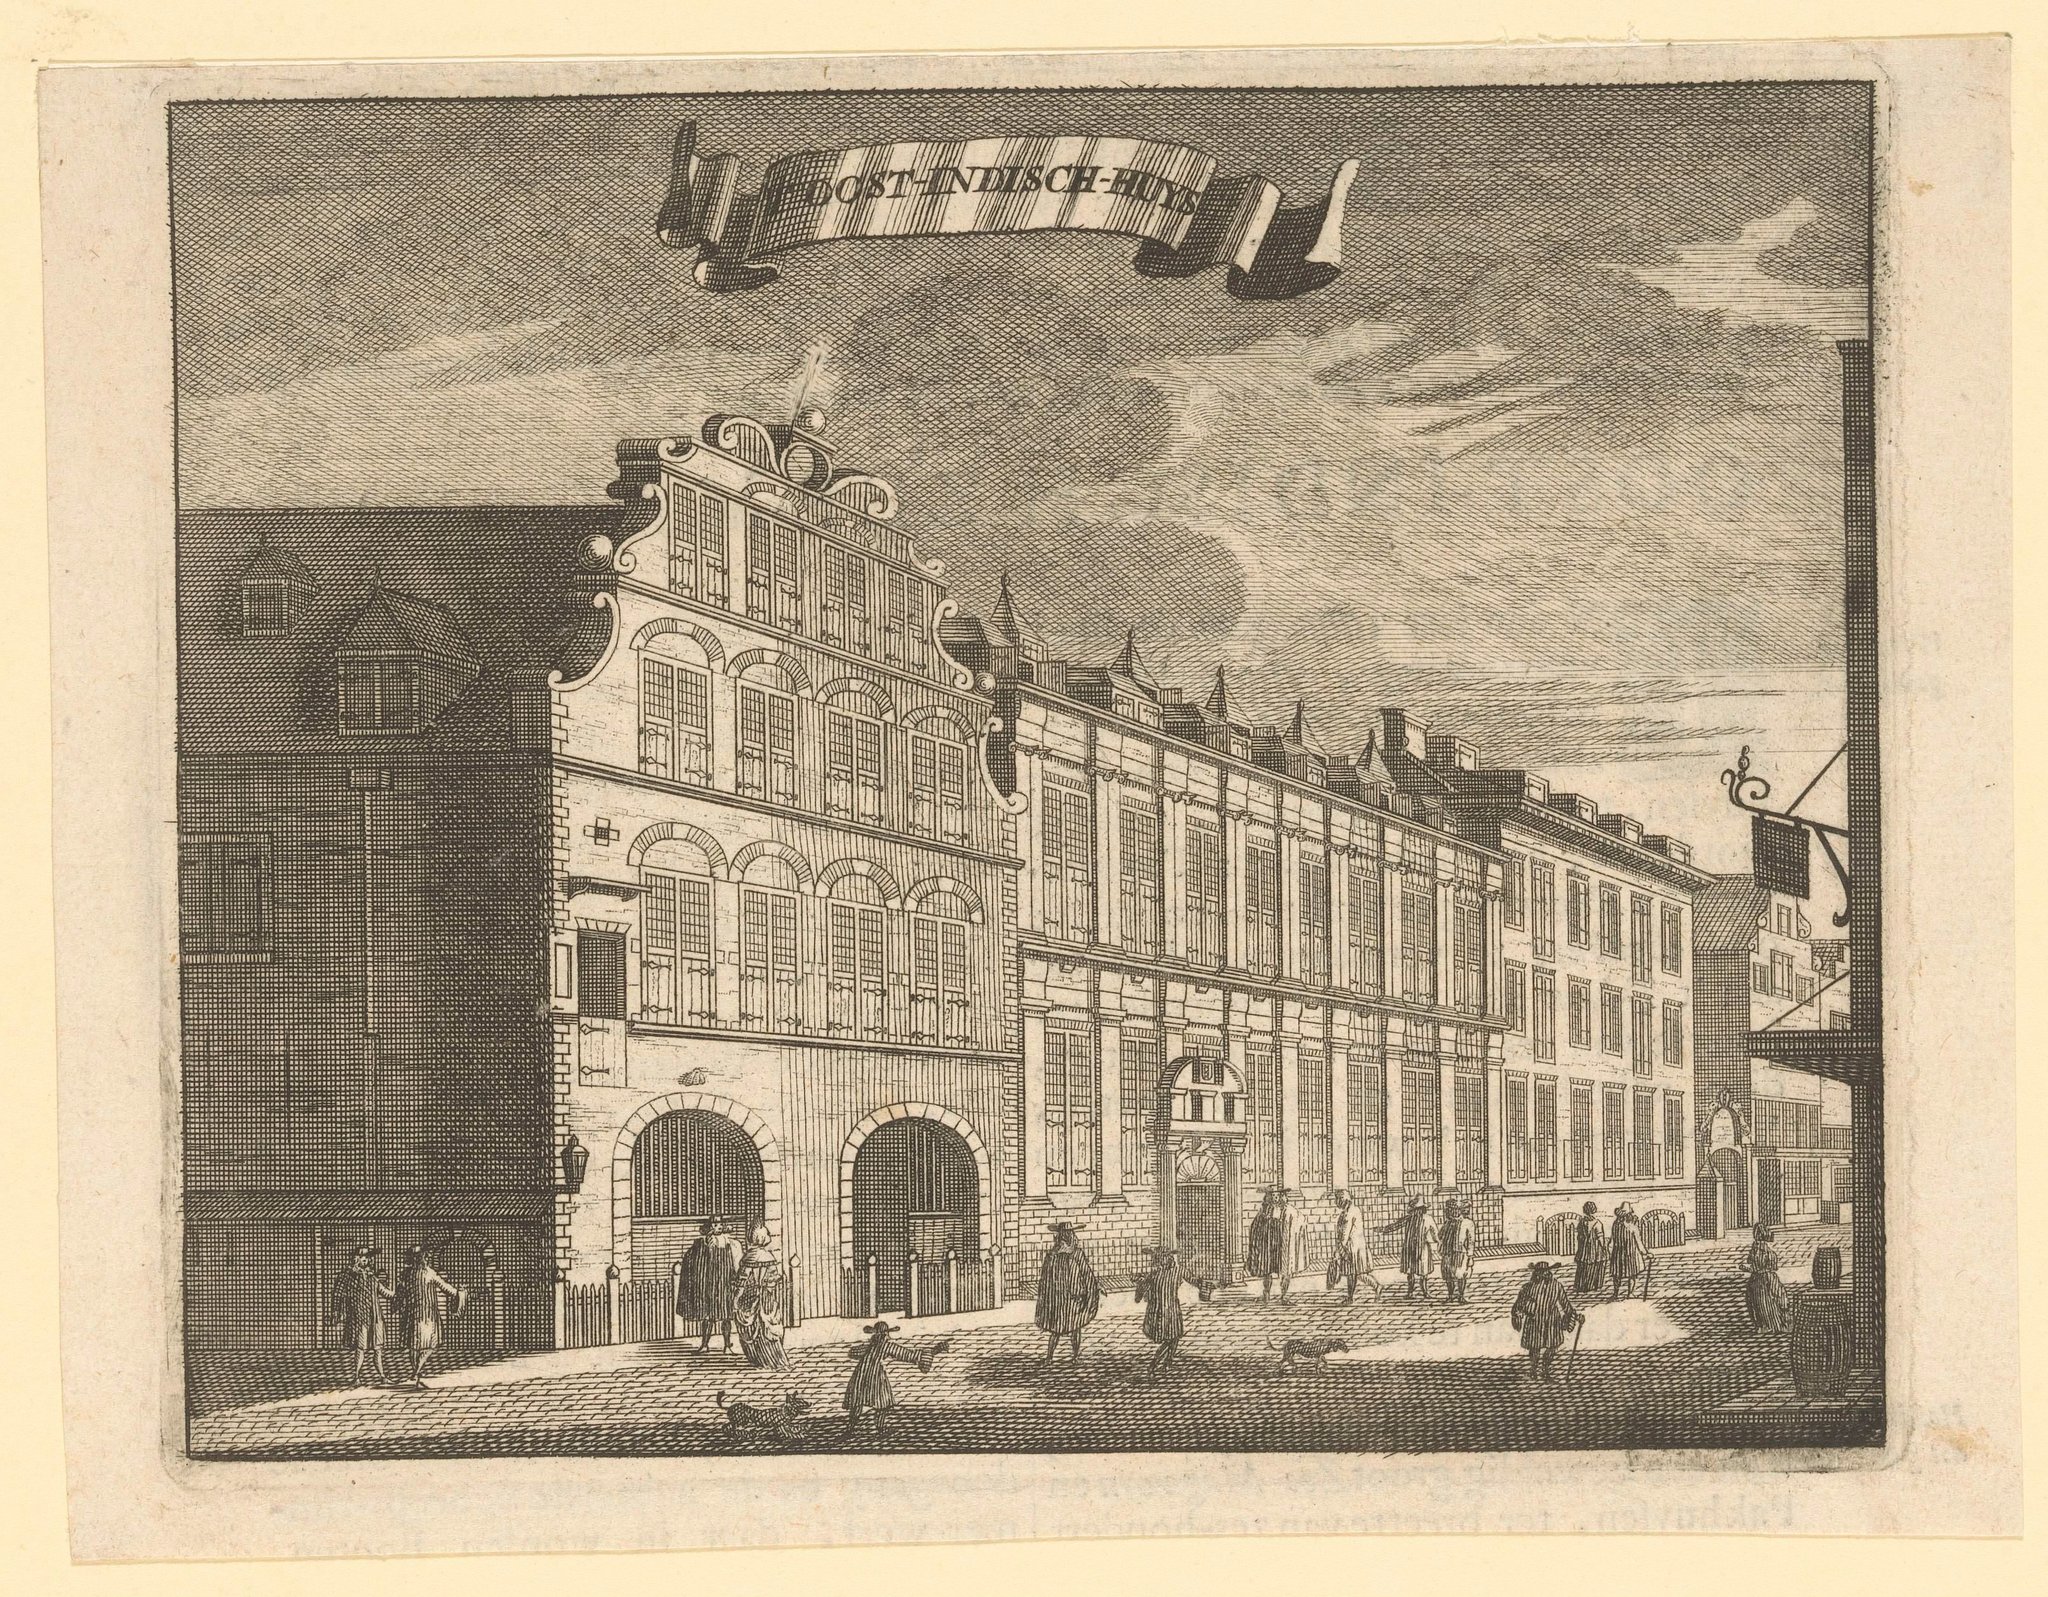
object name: print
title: t Oost-Indisch-Huys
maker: Anonymous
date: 1693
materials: paper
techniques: engraving, etching, letterpress printing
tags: trade-company, exterior ~ representation of a building, street (+ city(-scape) with figures, staffage)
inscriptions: collector's mark: Lugt 2228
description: Prent gebruikt in: Commelin, Caspar. Beschryvinge van Amsterdam, zynde een naukeurige verhandelinge van desselfs eerste oorspronk uyt (…). 2 delen. 2e druk. Amsterdam: Andries van Damme, Johannes Ratelband, weduwe A. van Aaltwyk en Hermanus Uytwerf, 1726. Eerdere staat van prent ook gebruikt in: Commelin, Caspar. Beschryvinge van Amsterdam, desselfs eerste oorspronk uyt den Huyse (…). 2 delen. Amsterdam: Abraham Wolfgang, Gillis Janssonius van Waesberge, Johannes Janssonius van Waesberge II, weduwe Dirk Boom I, Hendrick Boom en Rembertus Goethals, 1693. En in: Commelin, Caspar. Beschryvinge van Amsterdam, zynde een naukeurige verhandelinge van desselfs eerste oorspronk uyt (…). 2 delen. Amsterdam: weduwe Aart Dircksz Oossaan, 1694.